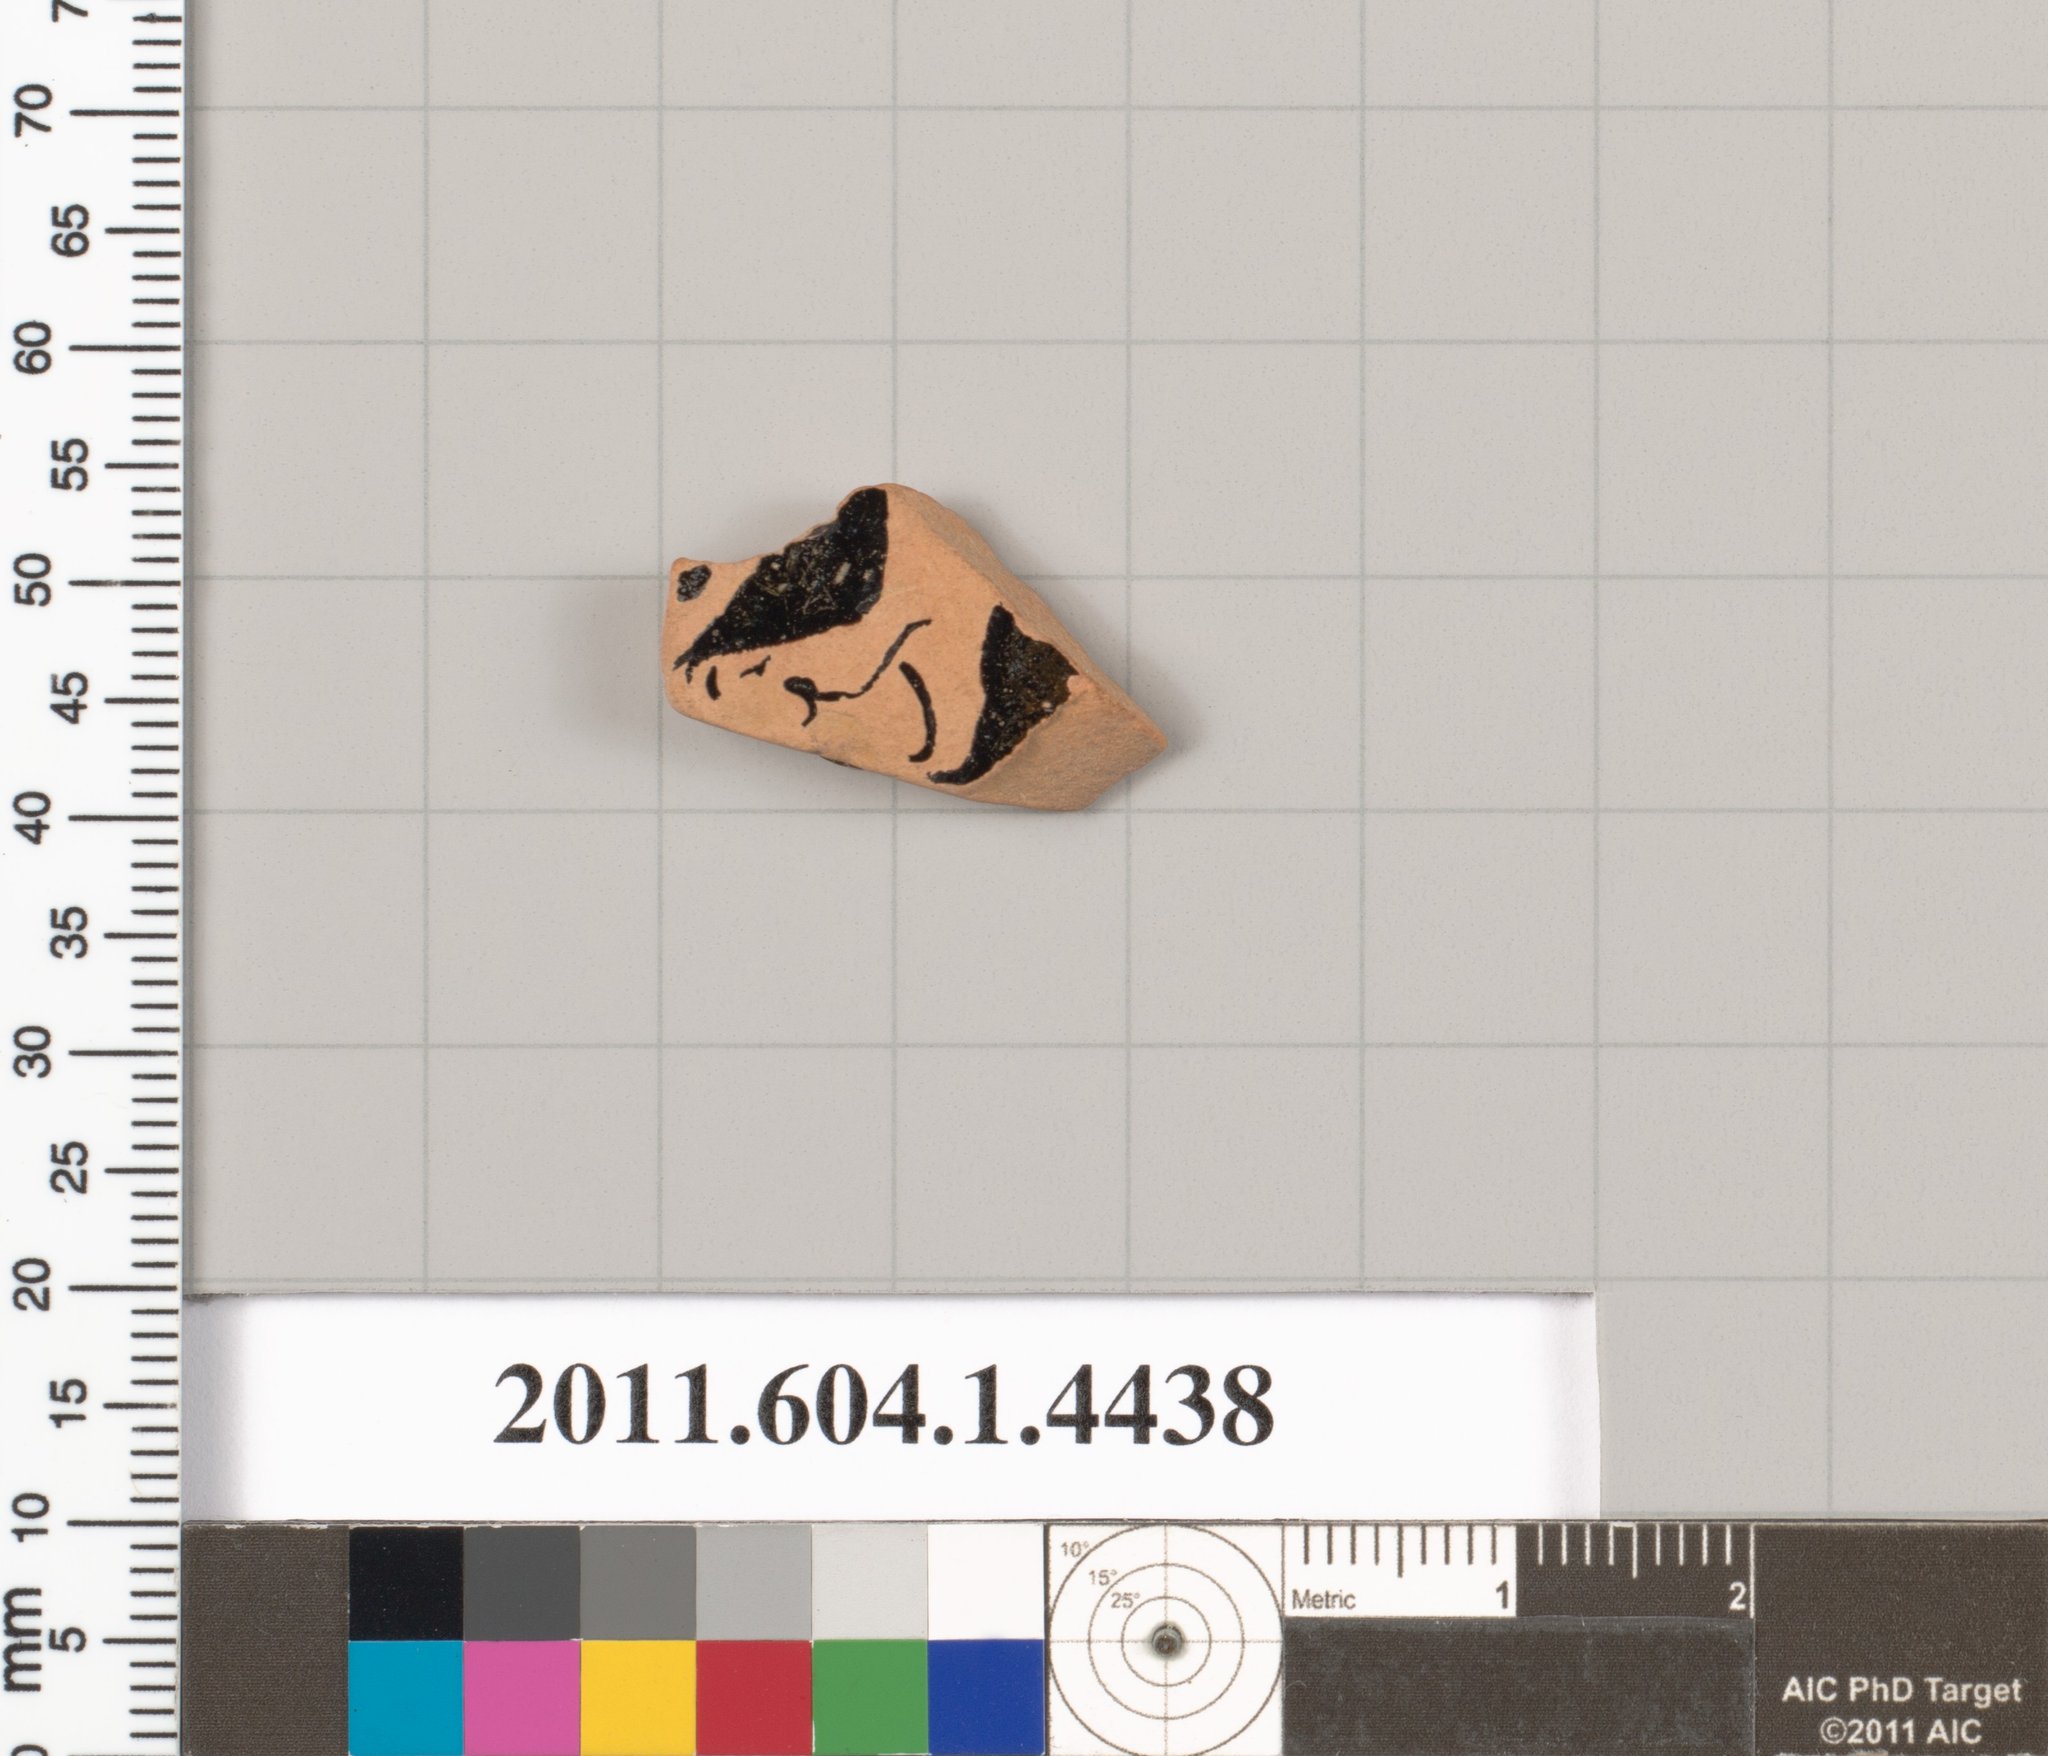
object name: kylix fragment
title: Terracotta fragment of a kylix (drinking cup)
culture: greek, attic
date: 475-451 BCE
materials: terracotta